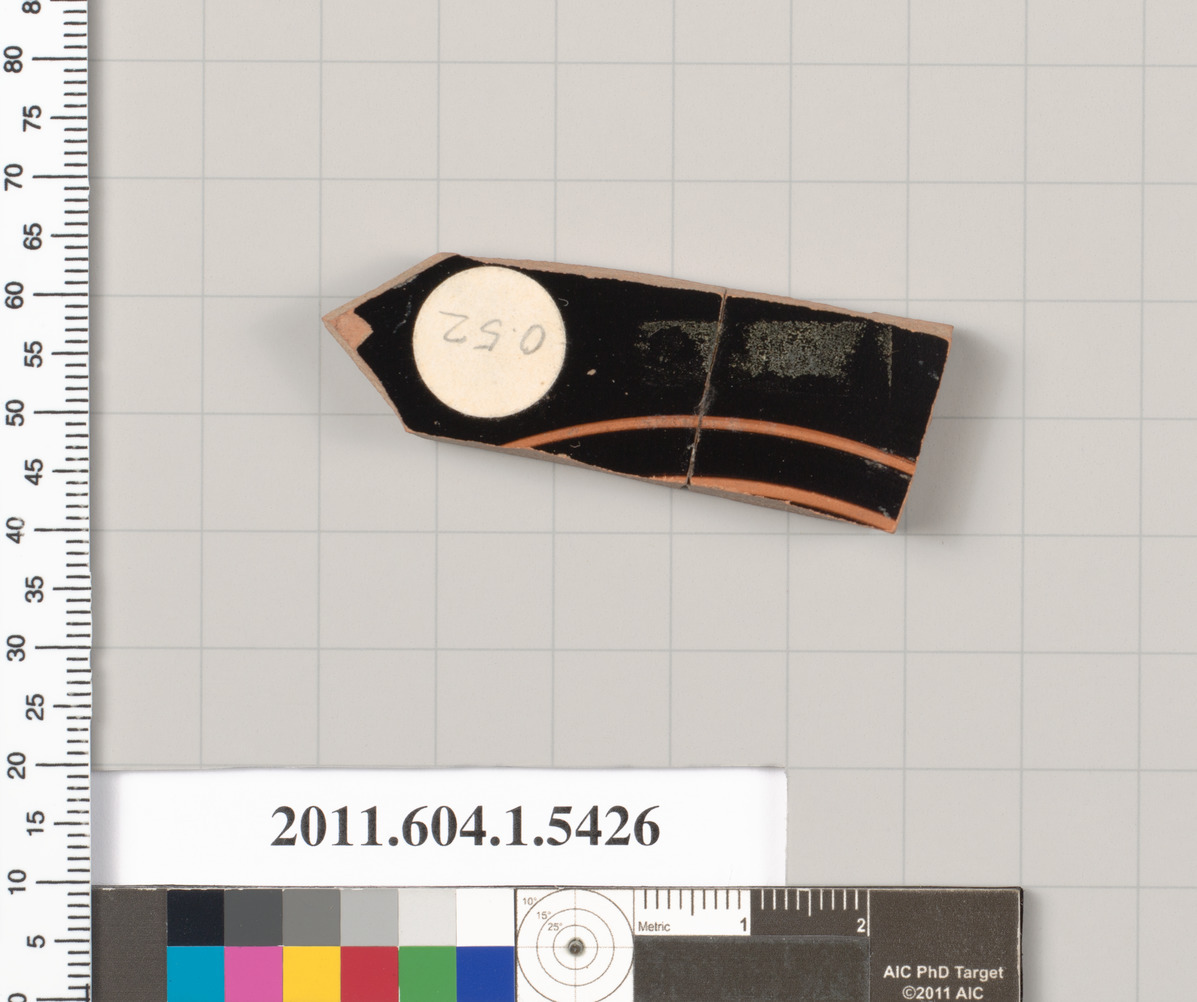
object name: kylix fragment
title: Terracotta fragment of a kylix (drinking cup)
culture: greek, attic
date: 500-480 BCE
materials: terracotta